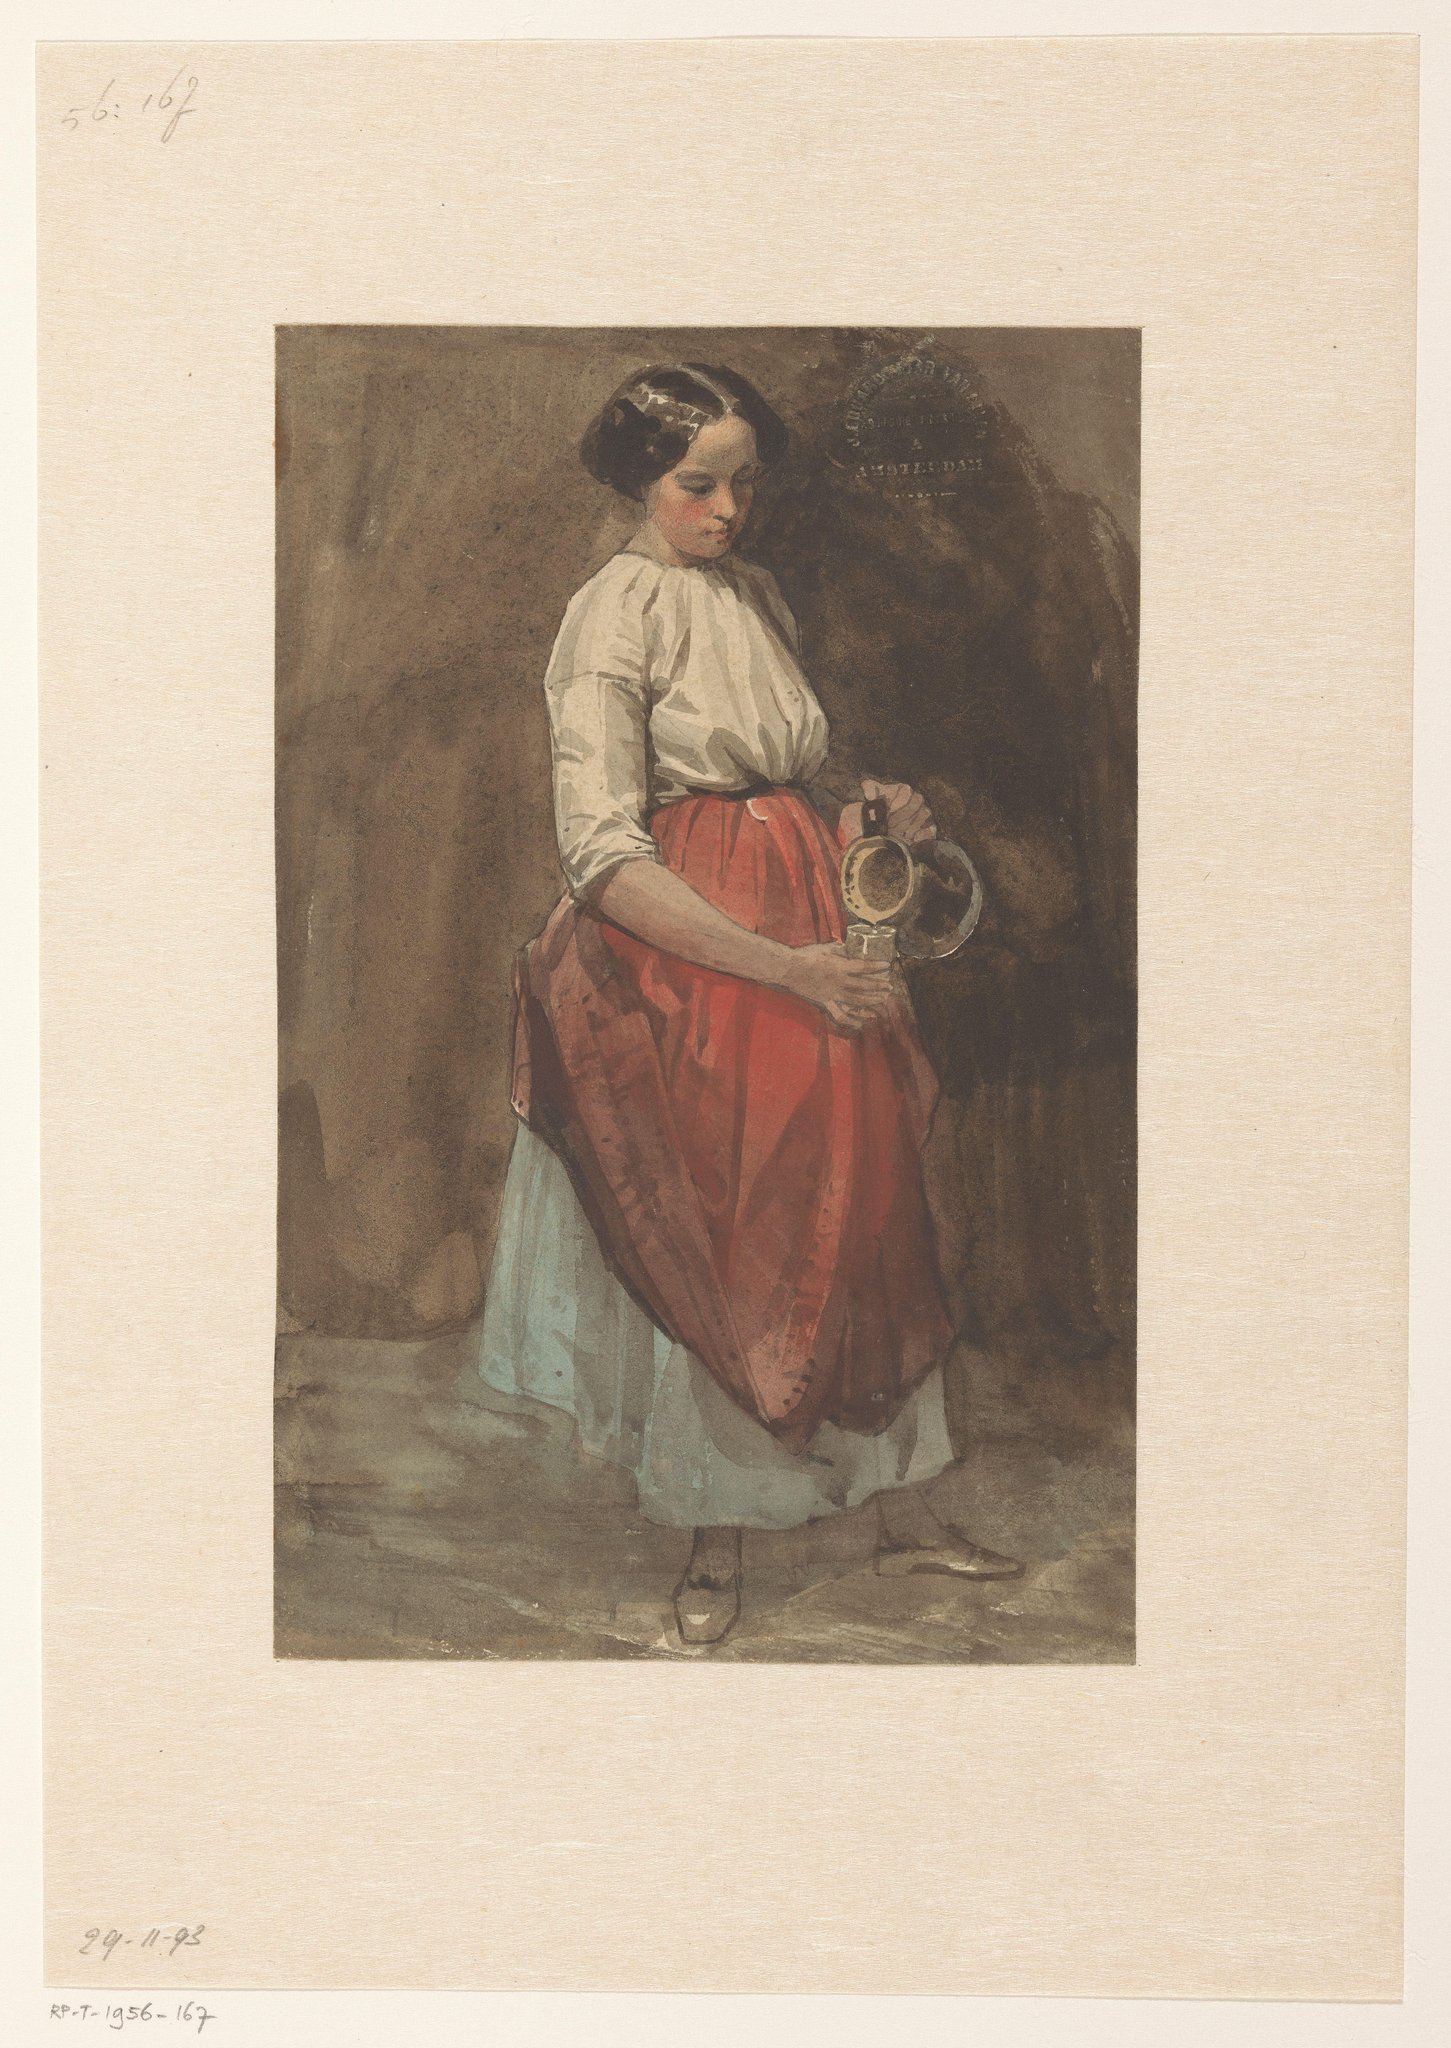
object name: watercolor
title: Staand meisje dat een glas inschenkt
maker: josef eduard tetar van elven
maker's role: draughtsman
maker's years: 1832-1859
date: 1842-1859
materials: paper, pencil, watercolor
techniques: brush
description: Staand meisje met rood schort, uit een kan in een glas schenkend.